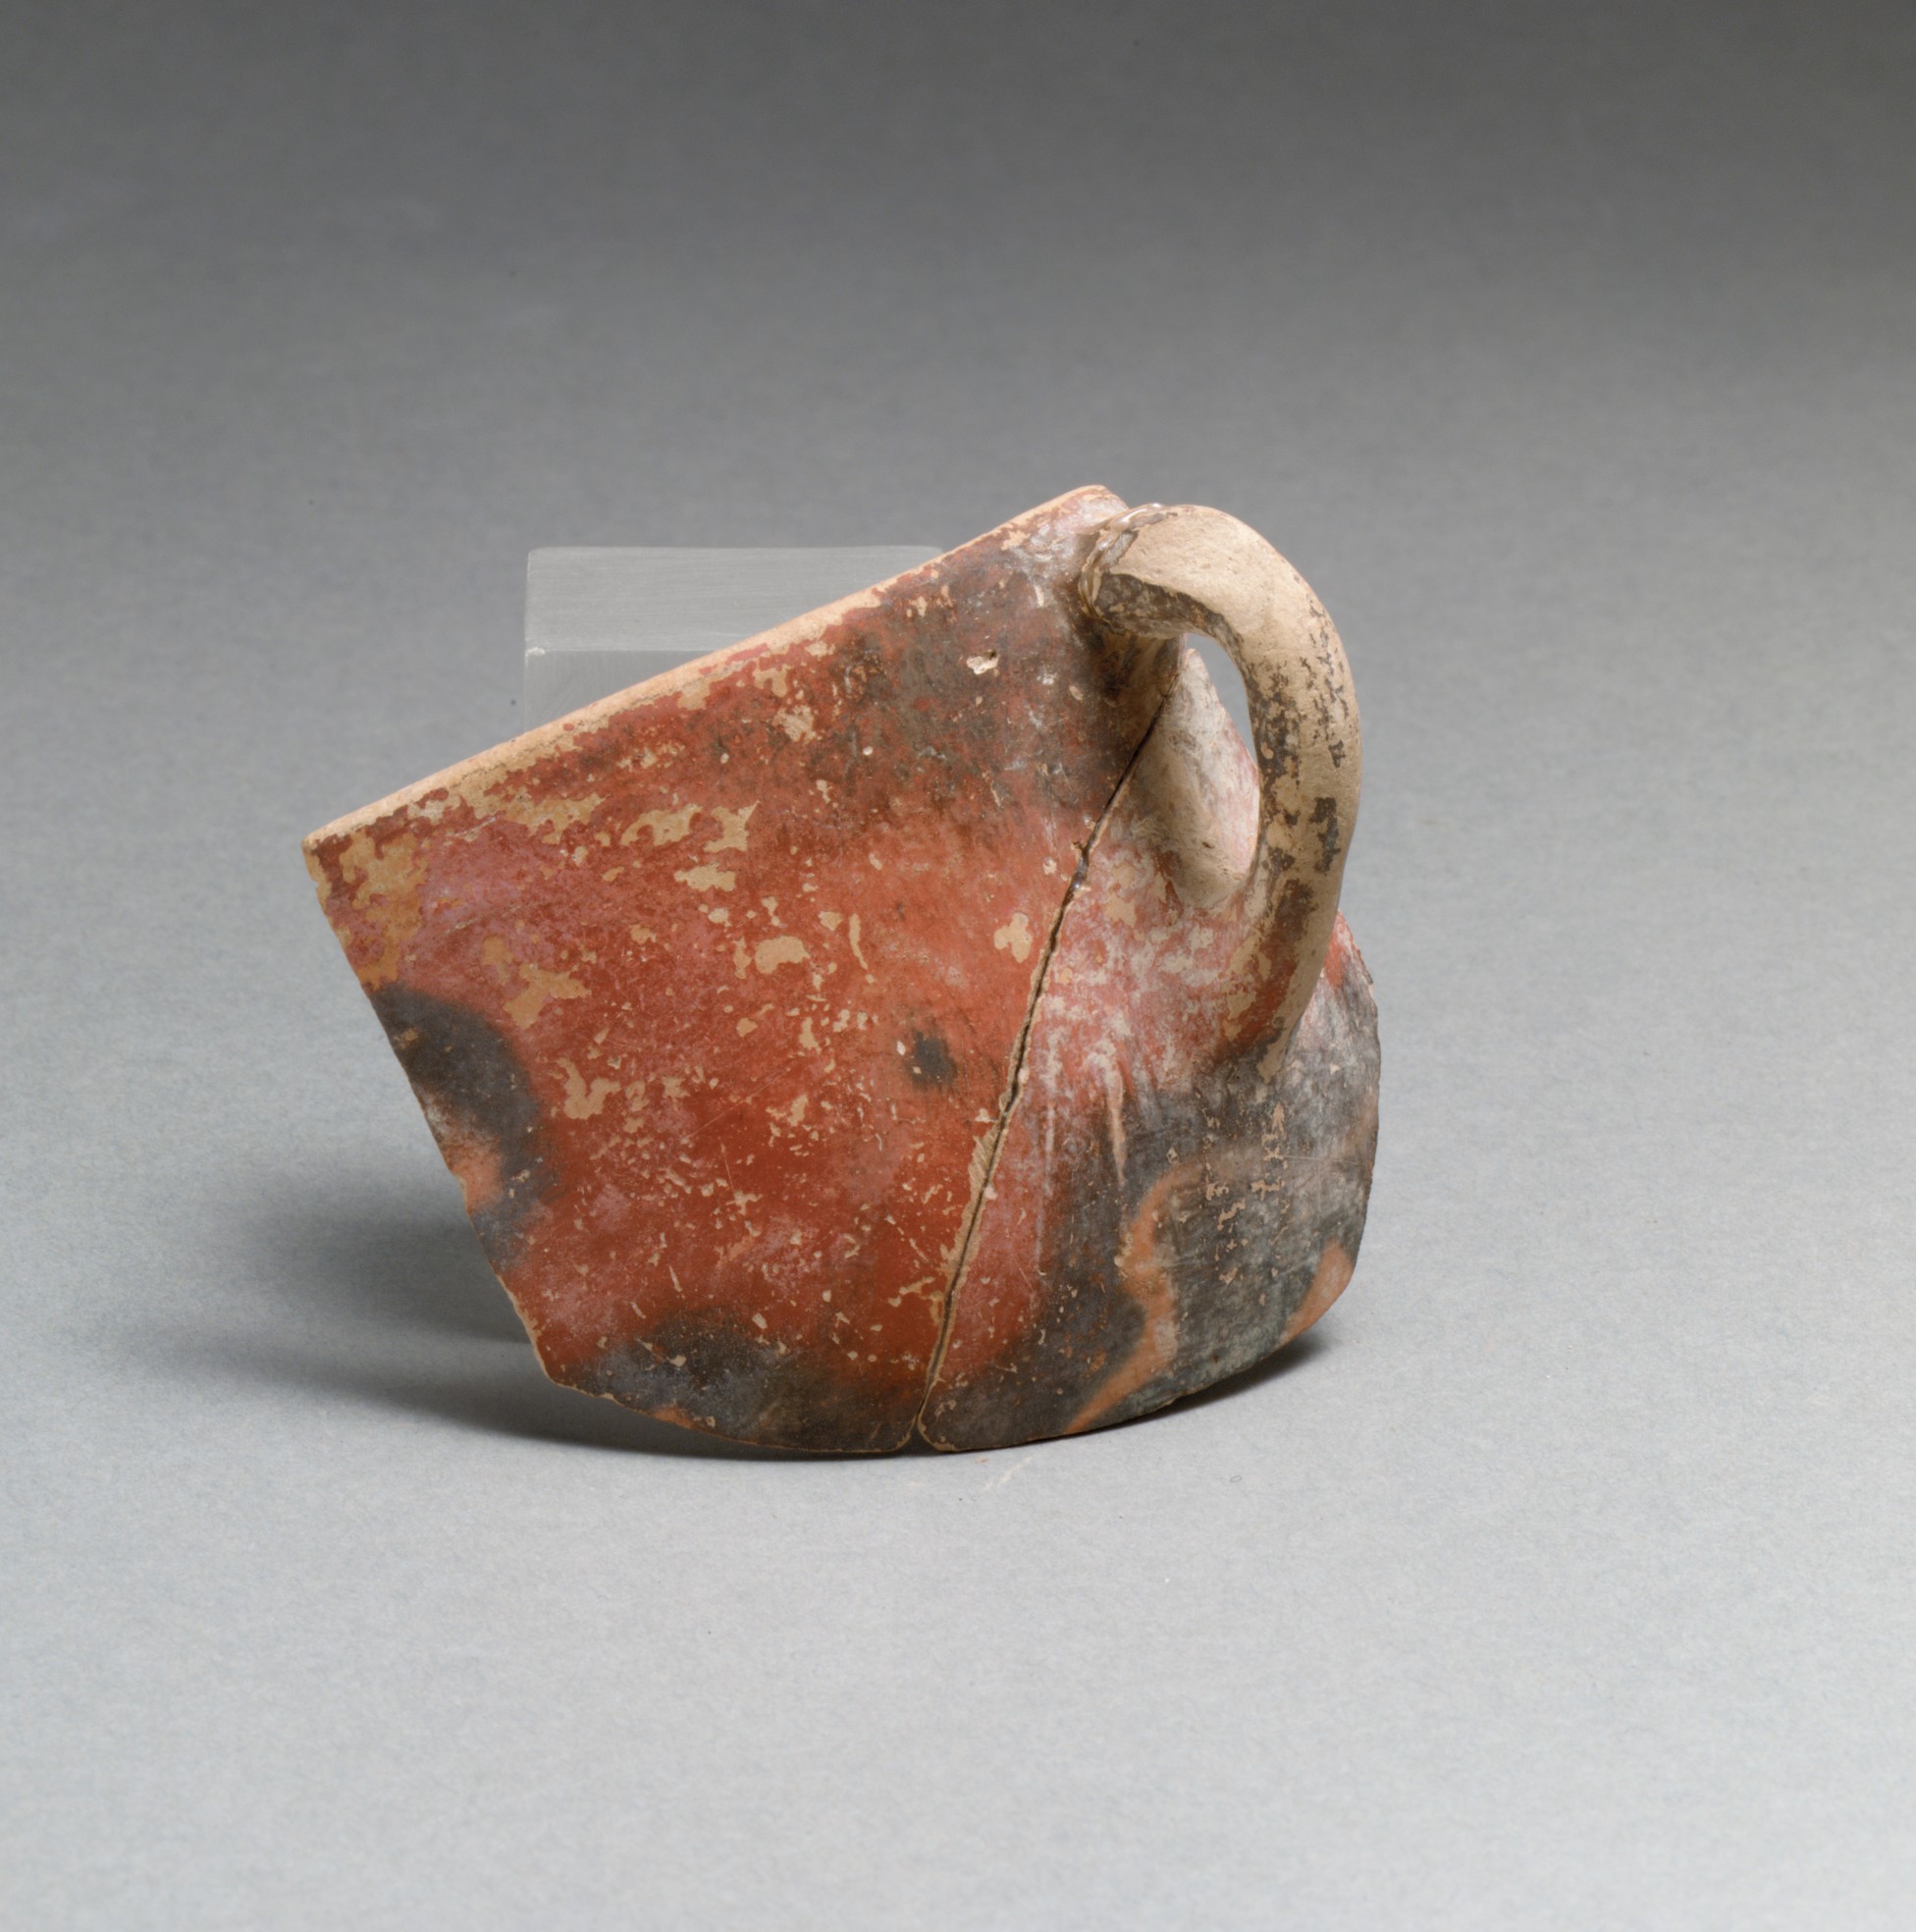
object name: cup, fragment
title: Terracotta rim, body and handle from a cup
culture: minoan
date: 2900-2300 BCE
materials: terracotta